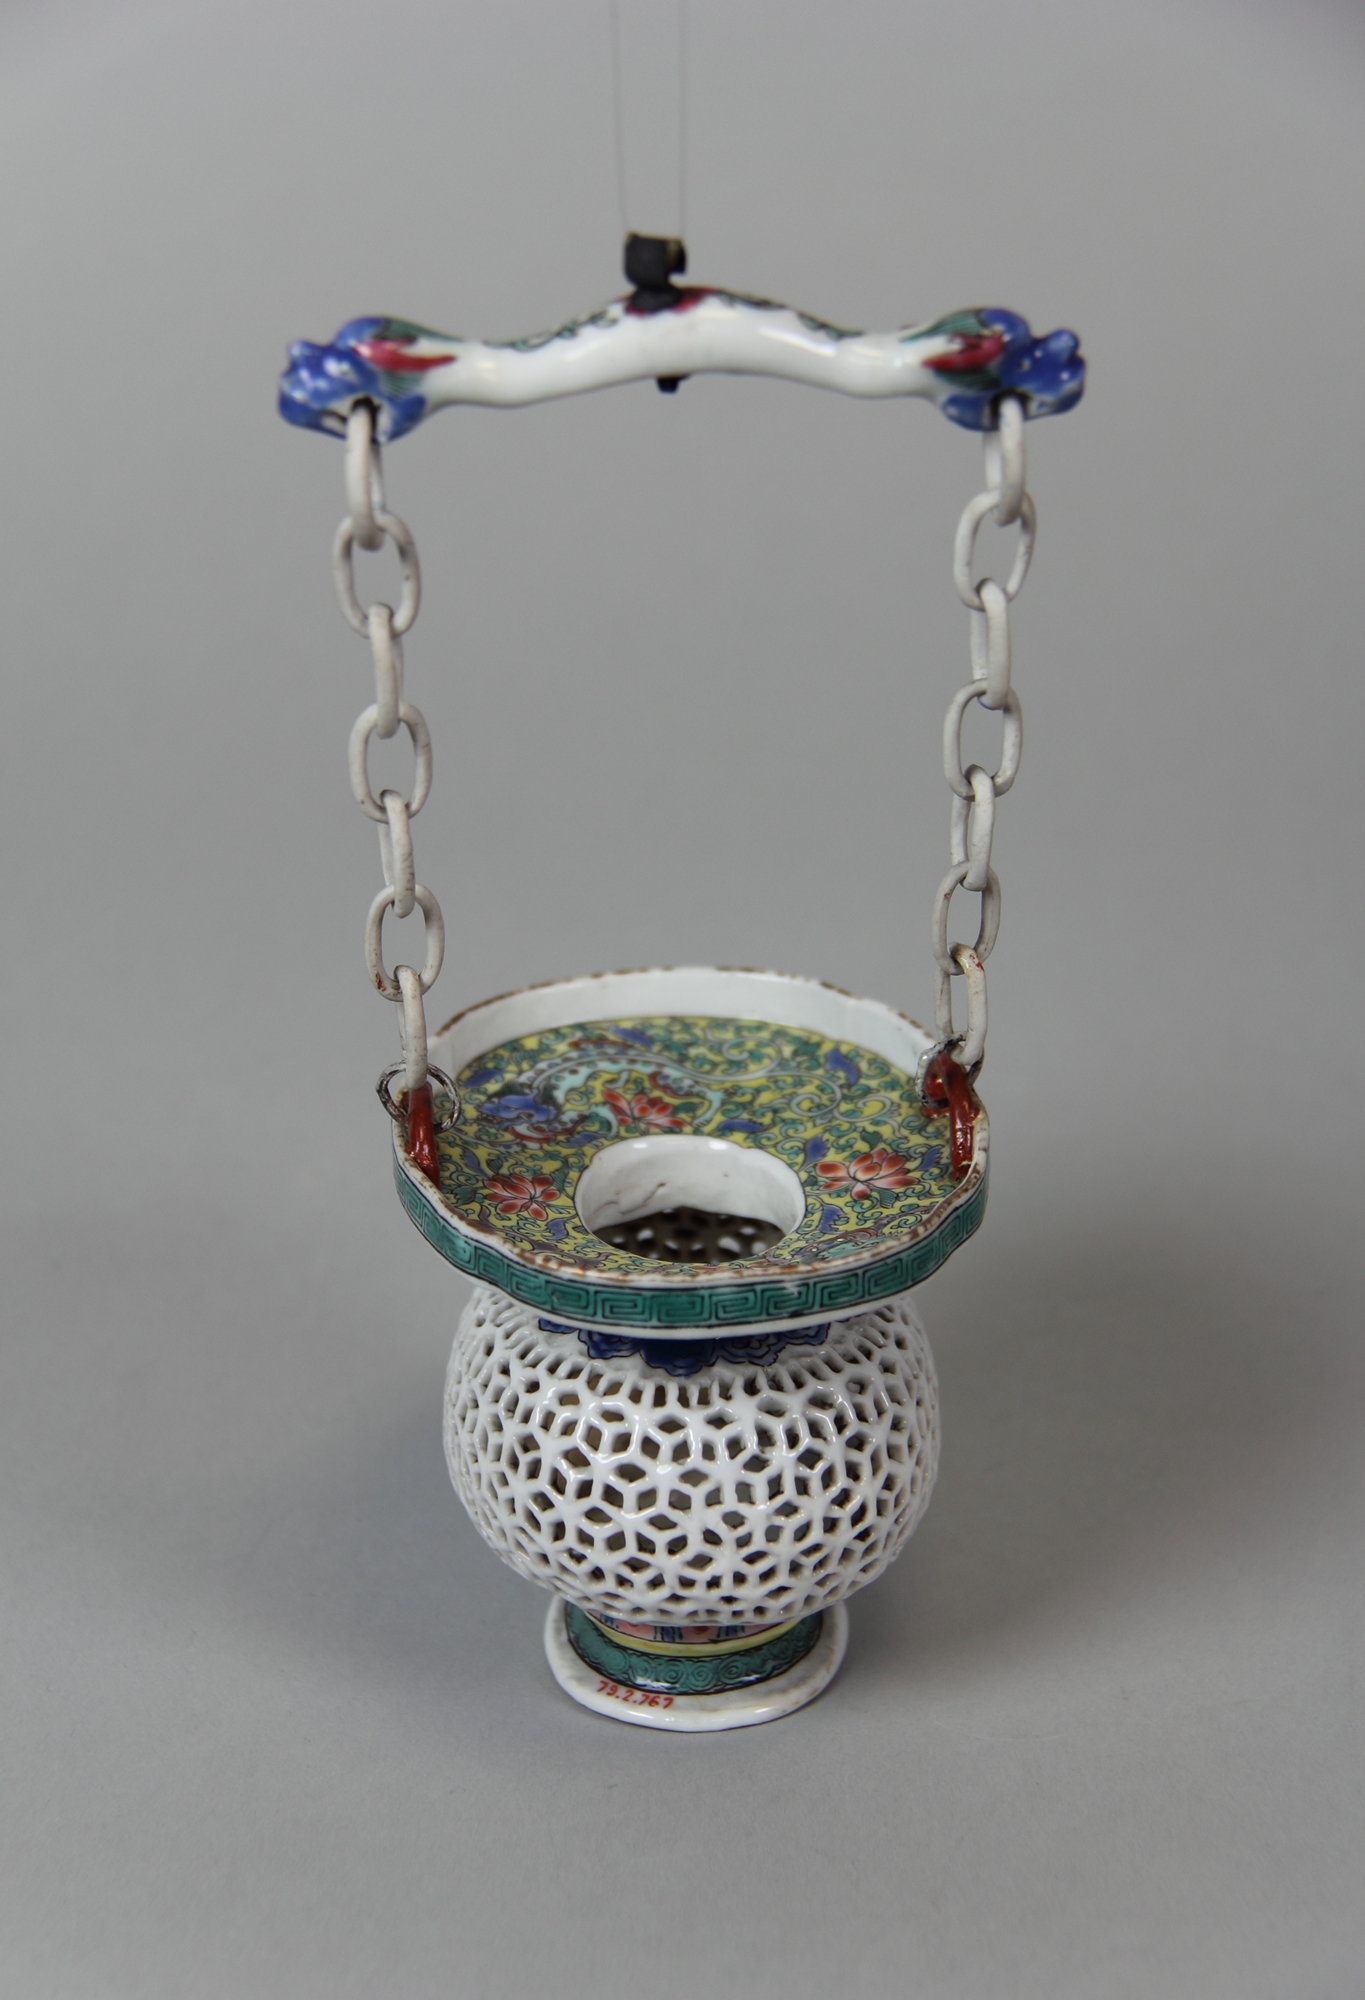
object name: hanging basket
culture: chinese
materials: enamel, porcelain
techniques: overglaze, painting, polychrome